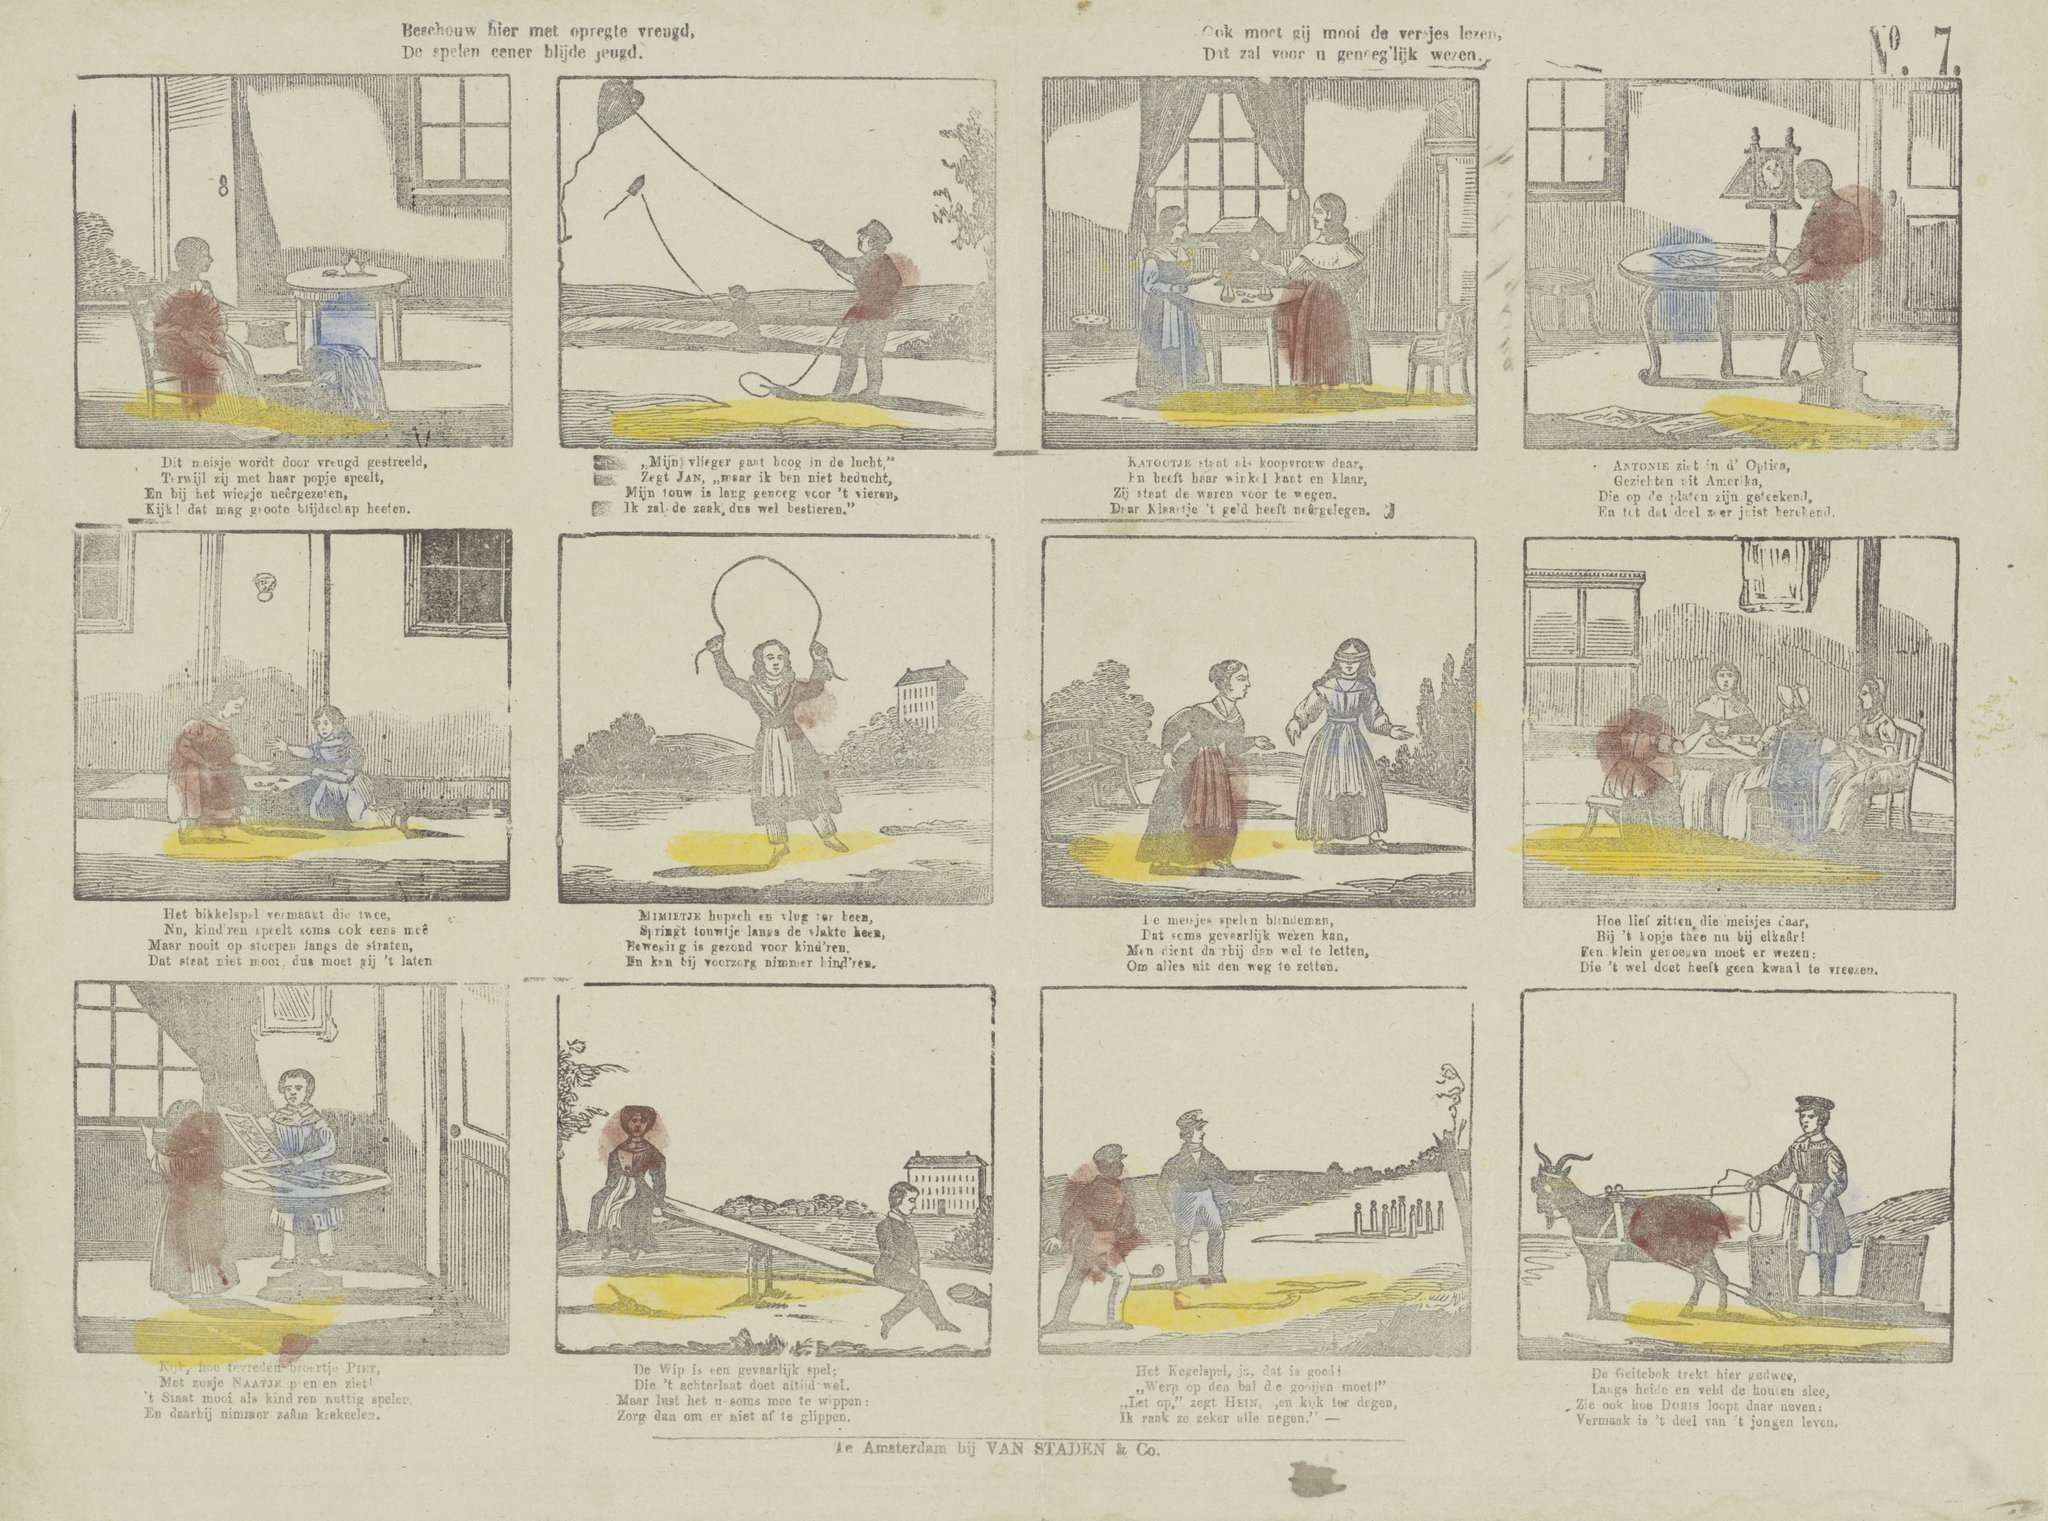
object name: print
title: Beschouw hier met opregte vreugd, / De spelen eener blijde jeugd, / Ook moet gij mooi de versjes lezen. / Dat zal voor u genoeglijk wezen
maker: Anonymous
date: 1850-1870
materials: paper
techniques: colour, letterpress printing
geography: amsterdam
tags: children's games and plays, blind-man's buff, (flying a) kite, jumping-rope games, seesaw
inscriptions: collector's mark: Lugt 2760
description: Blad met 12 voorstellingen van kinderspelen en bezigheden, zoals vliegeren, touwtjespringen en blindemannetje. Onder elke afbeelding een vierregelig vers. Rechtsboven genummerd: No. 7.